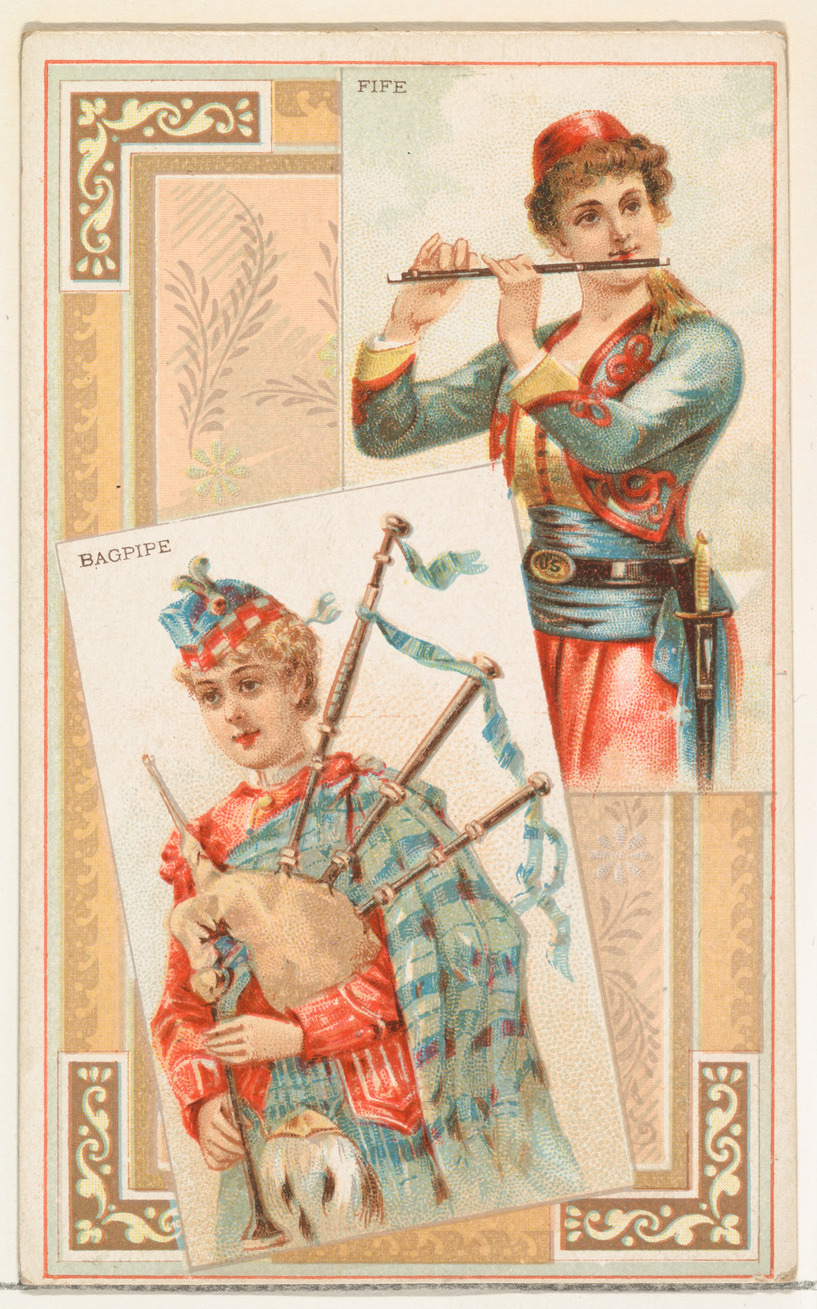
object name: print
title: Fife and Bagpipe, from the Musical Instruments series (N121) issued by Duke Sons & Co. to promote Honest Long Cut Tobacco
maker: w. duke, sons & co.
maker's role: publisher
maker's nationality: american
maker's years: 1870-1920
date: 1888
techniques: color lithograph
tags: men,women,bagpipes,flutes